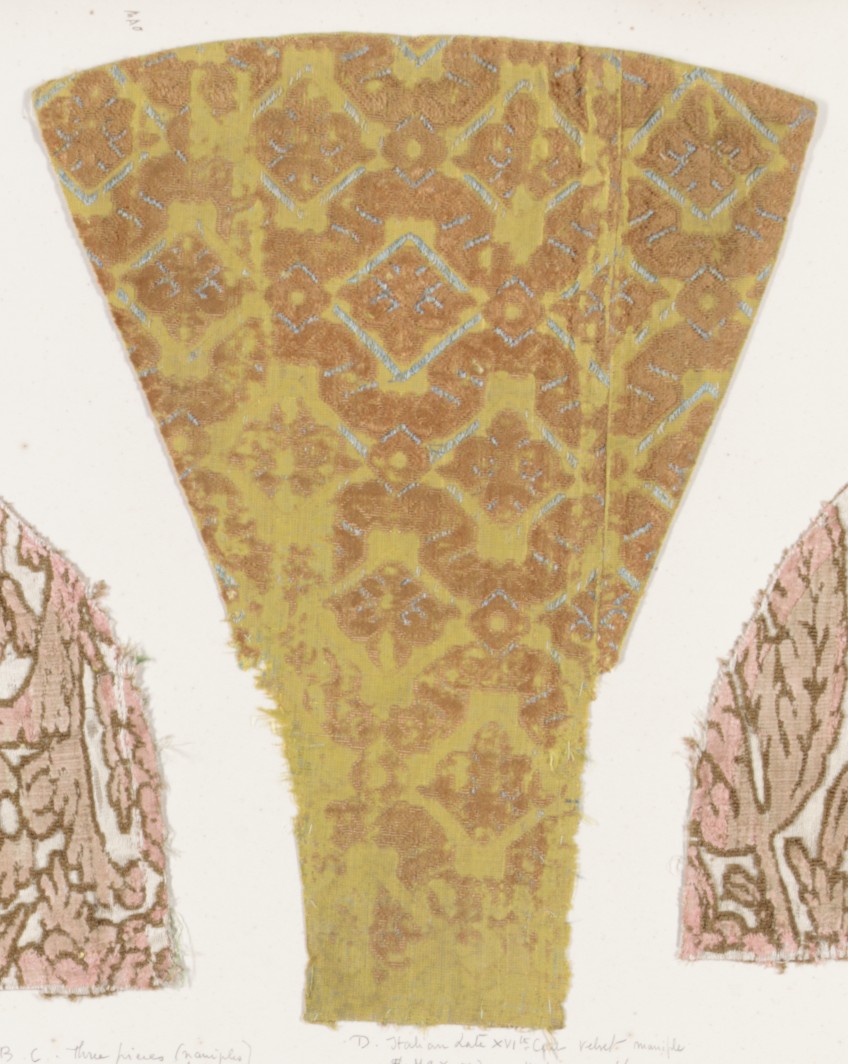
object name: fragment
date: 1567-1600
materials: silk